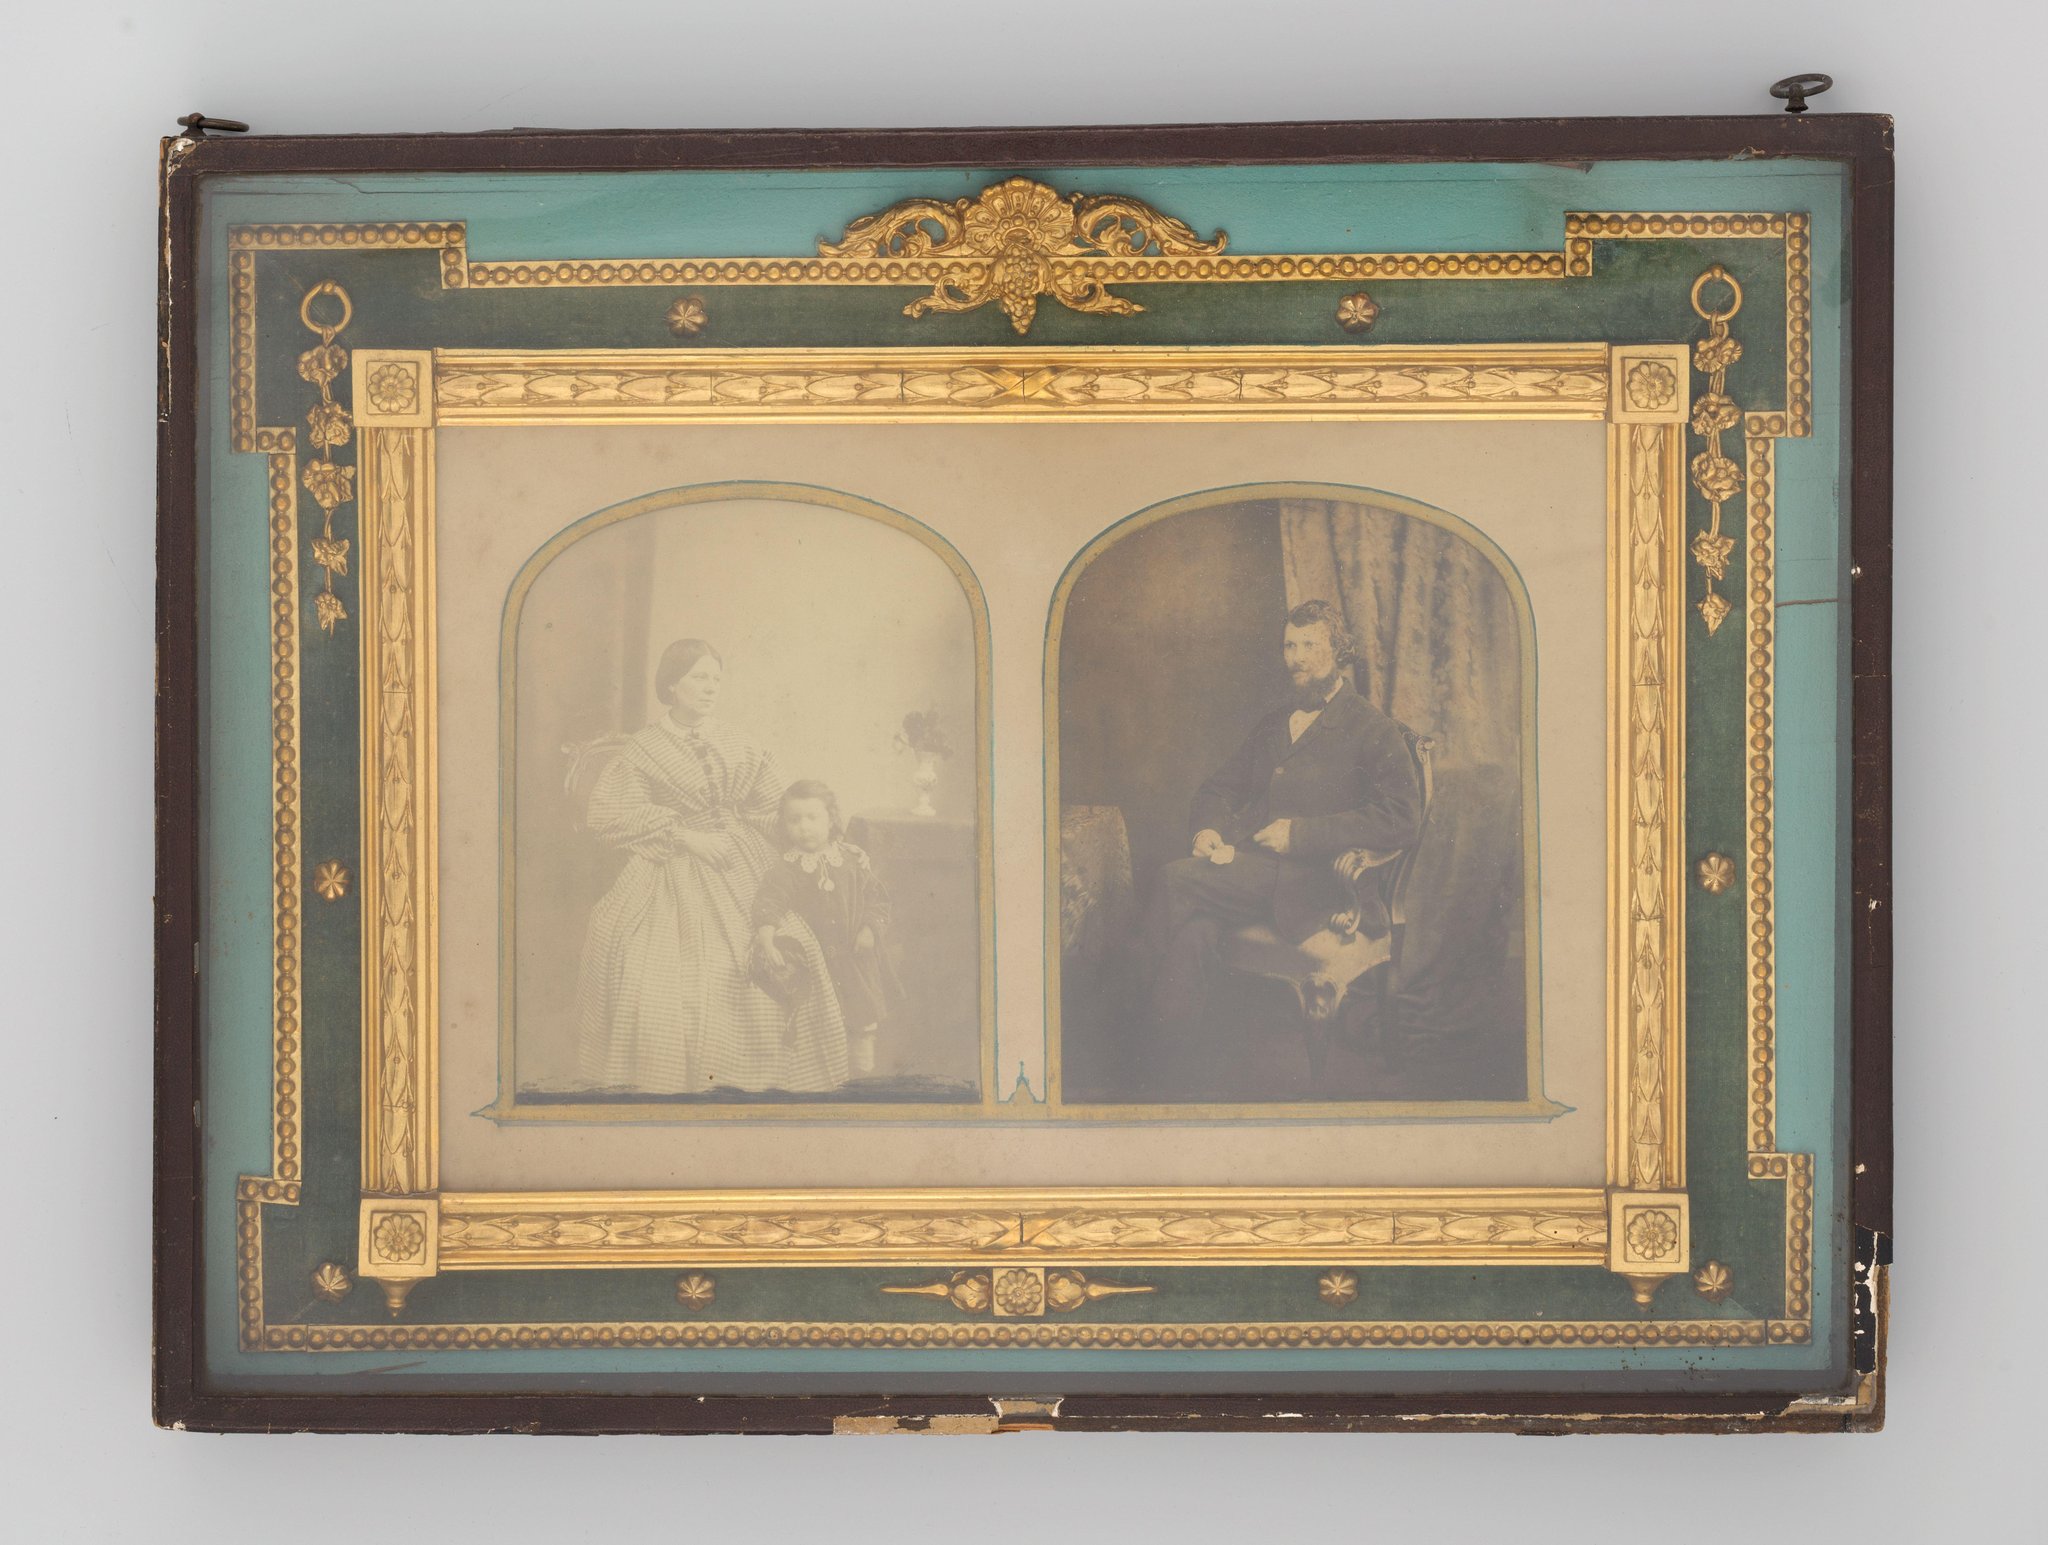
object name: photograph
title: Portret van een onbekende zittende man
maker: Anonymous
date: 1851-1900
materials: cardboard, glass, metal, paper, velvet, wood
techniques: albumen print, gilding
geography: france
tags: sitting figure, adult man, anonymous historical person portrayed